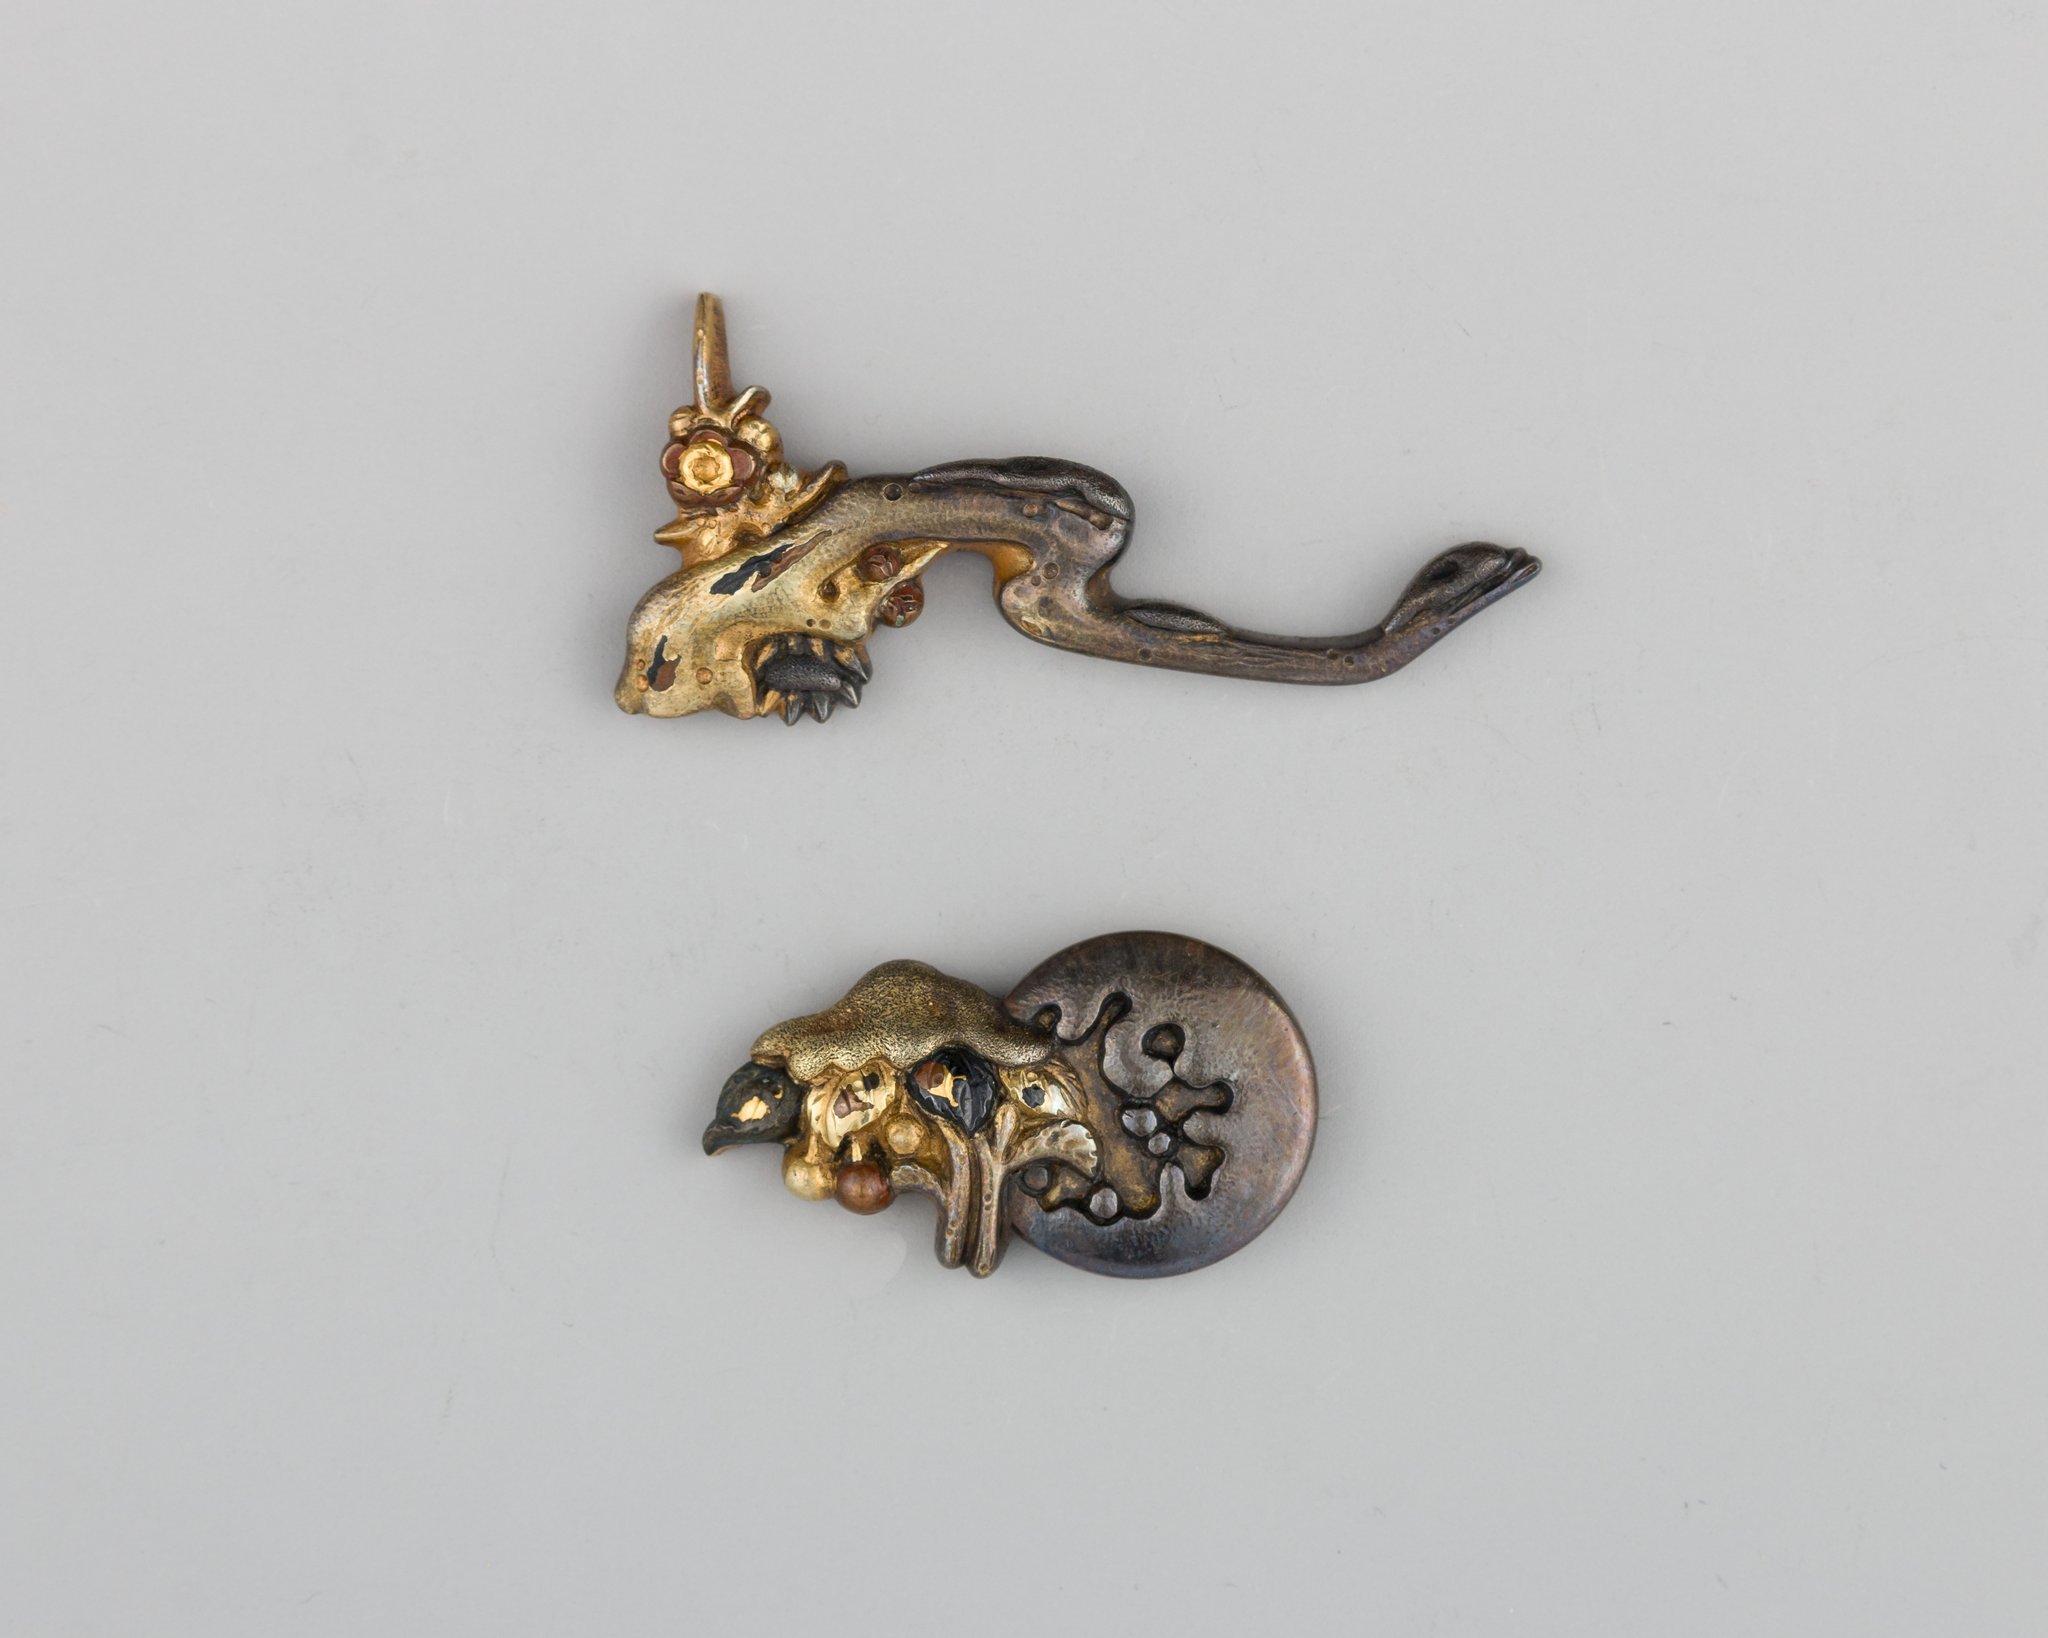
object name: pair of sword grip ornament menuki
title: Pair of Sword-Grip Ornaments (Menuki)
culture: japanese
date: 1859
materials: copper, gold alloy, gold, silver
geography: japan